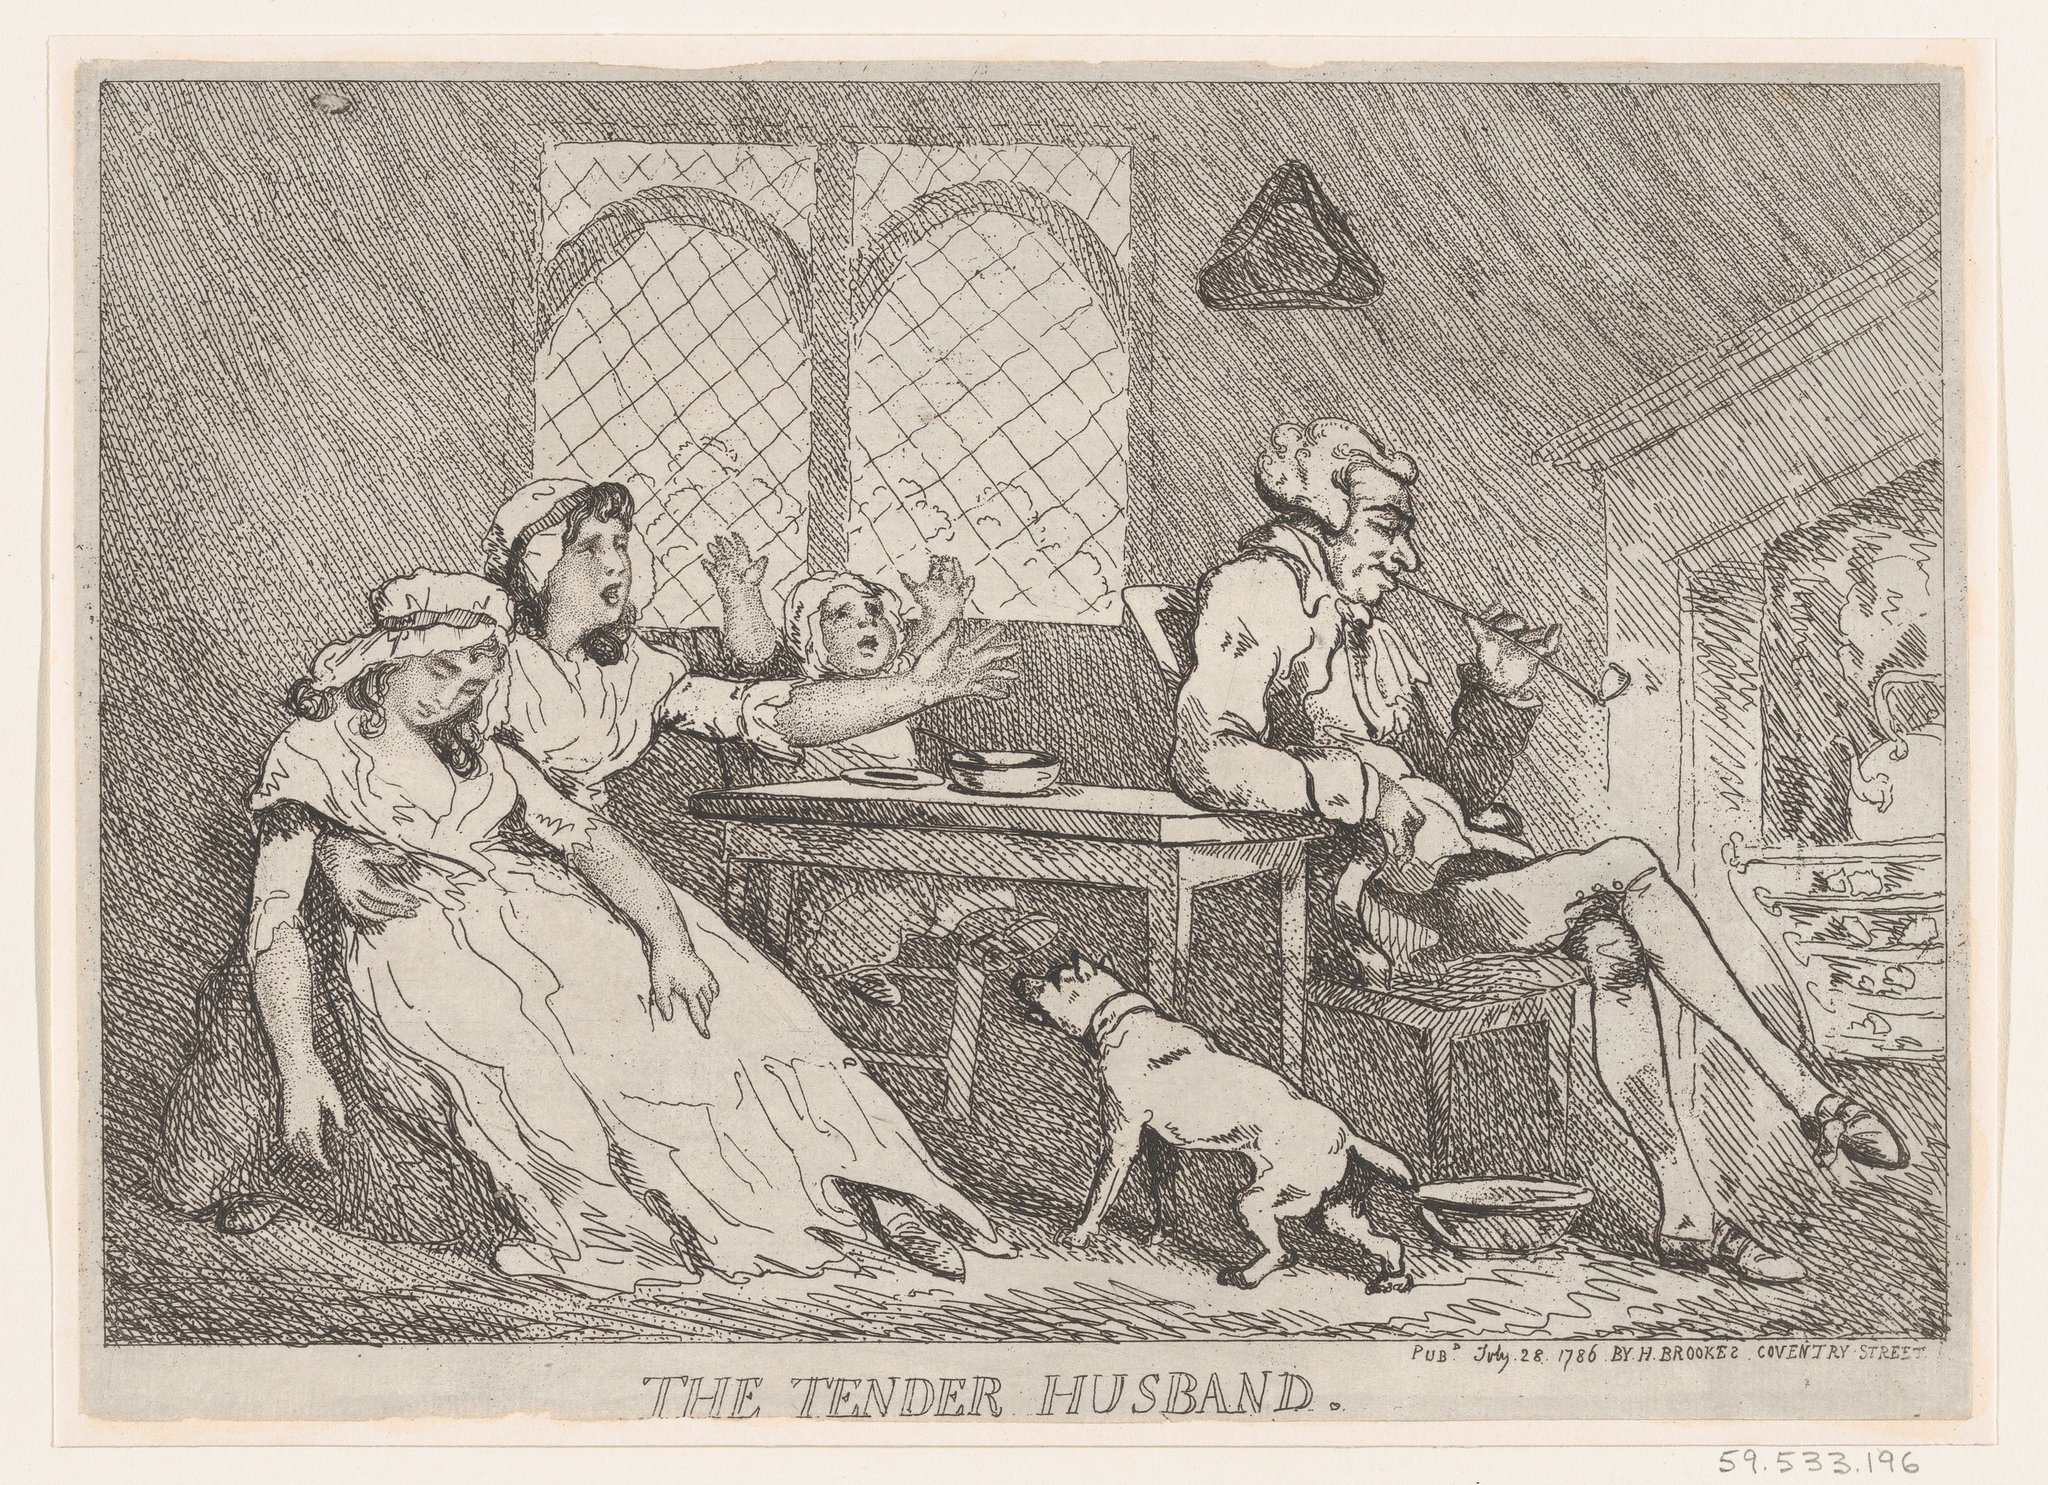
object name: print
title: The Tender Husband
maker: thomas rowlandson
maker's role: artist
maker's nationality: british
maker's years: 1757-1827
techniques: etching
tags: boys,men,women,smoking,dogs